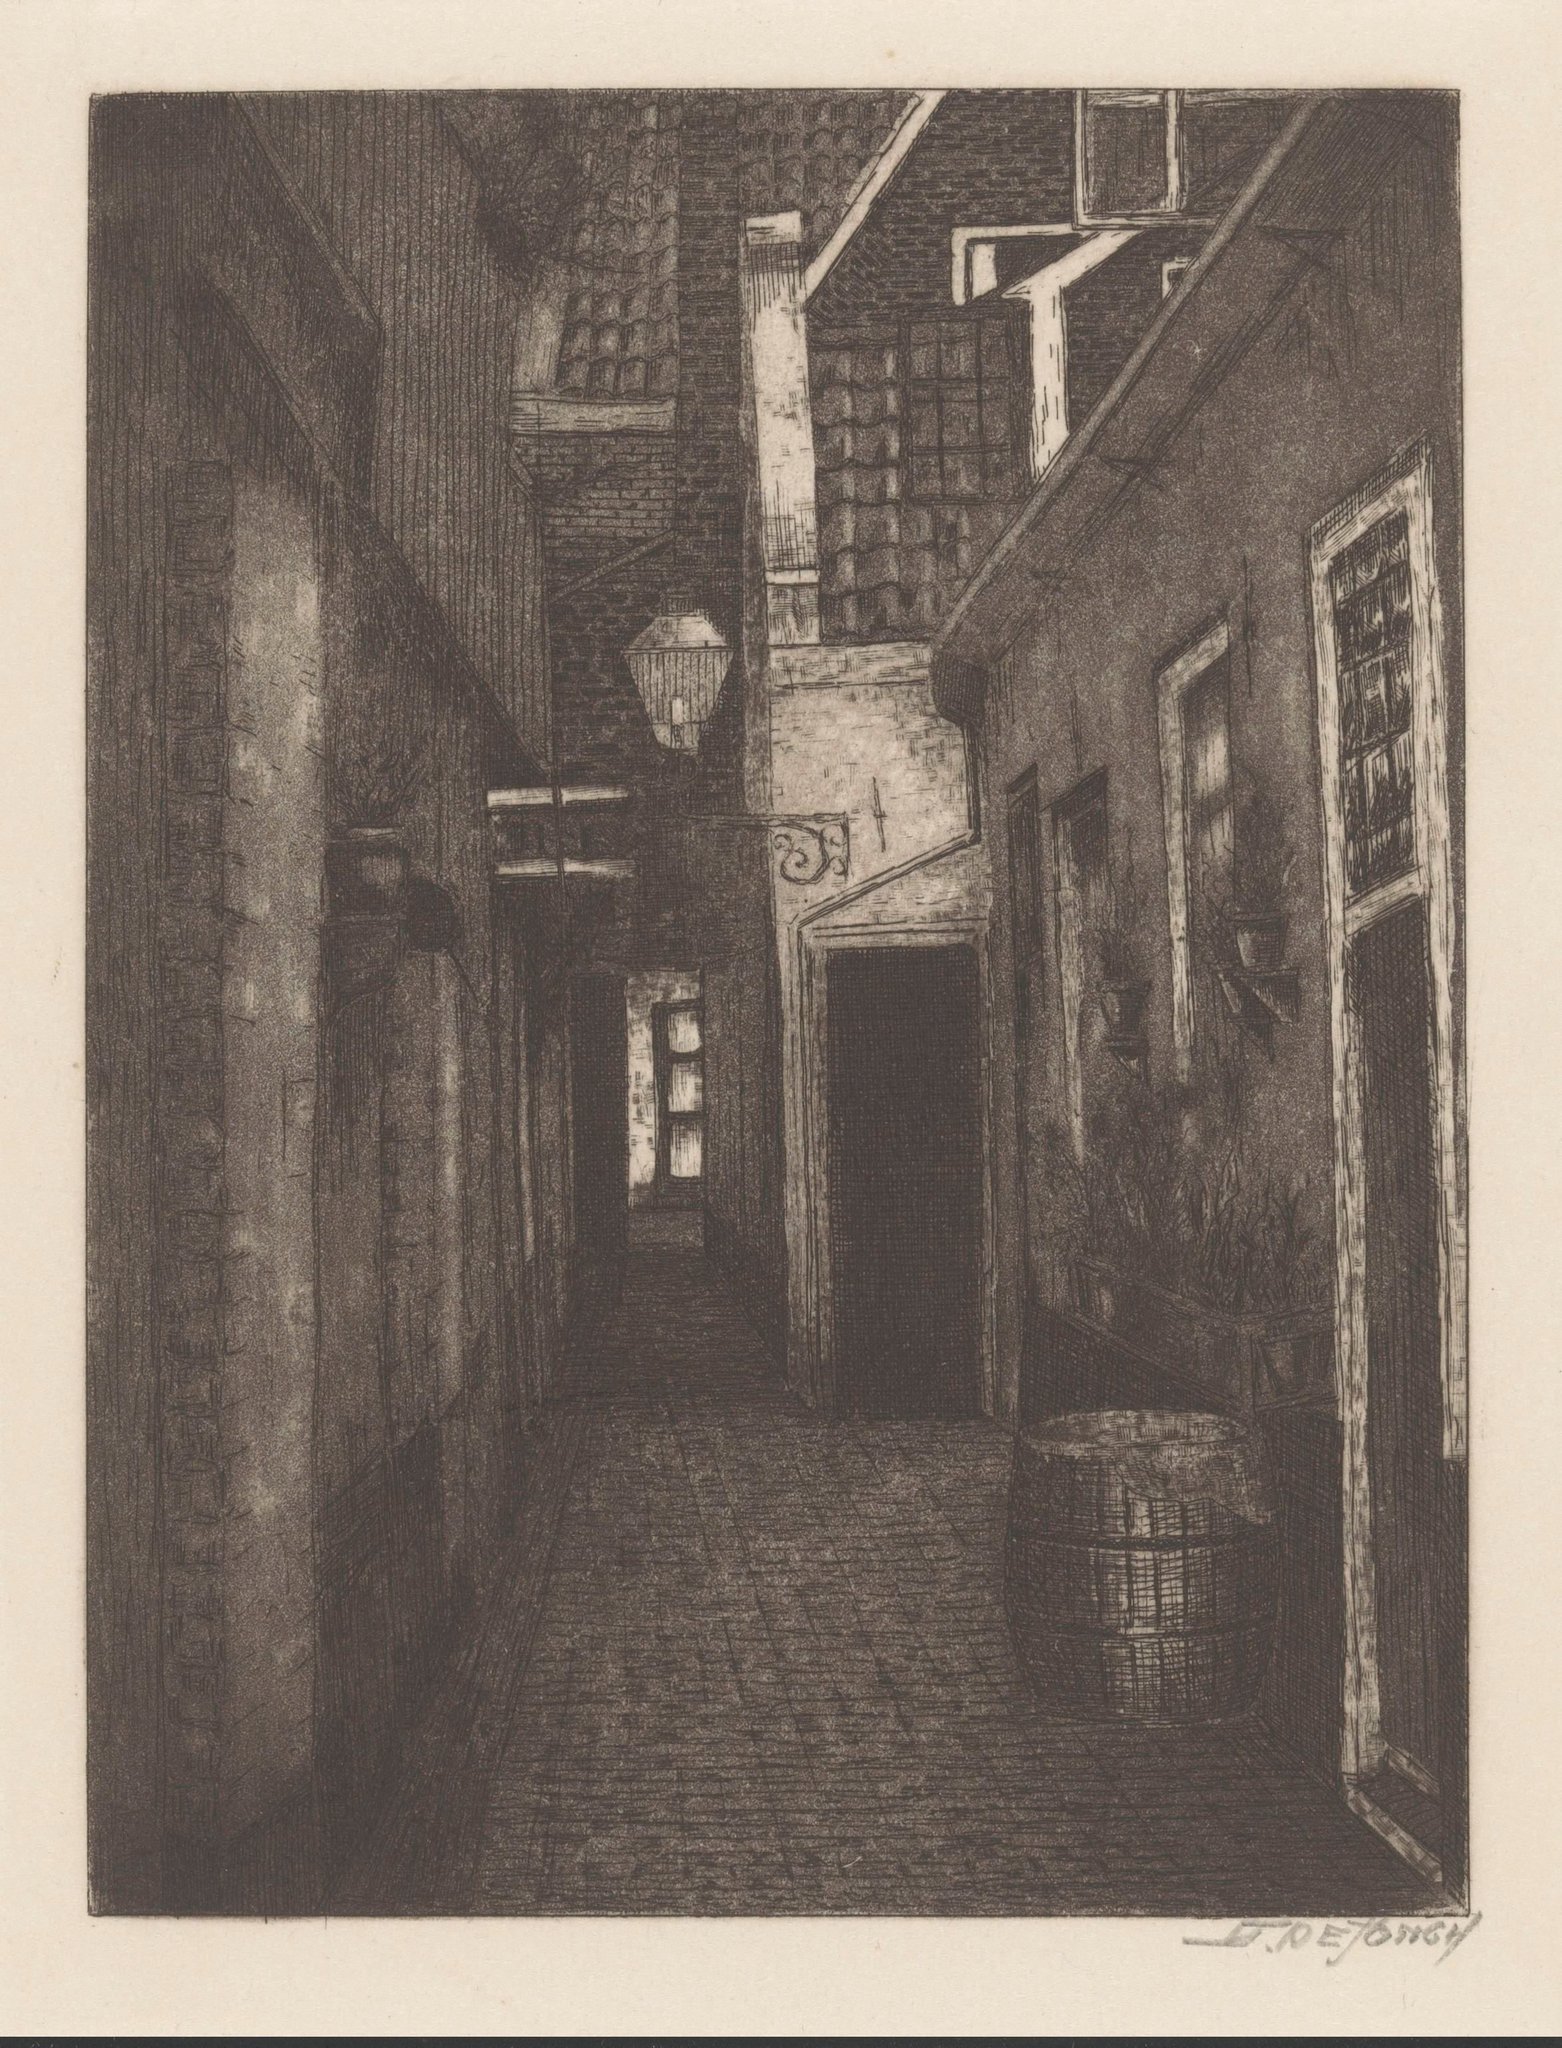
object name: print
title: Steeg bij avond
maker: s. de jongh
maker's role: print maker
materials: paper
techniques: etching, intaglio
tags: evening, lane, alley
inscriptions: collector's mark: Lugt 2228, collector's mark: Lugt 2760, inscription: ‘S. de Jongh Twijnstraat 43 bis A Utrecht’